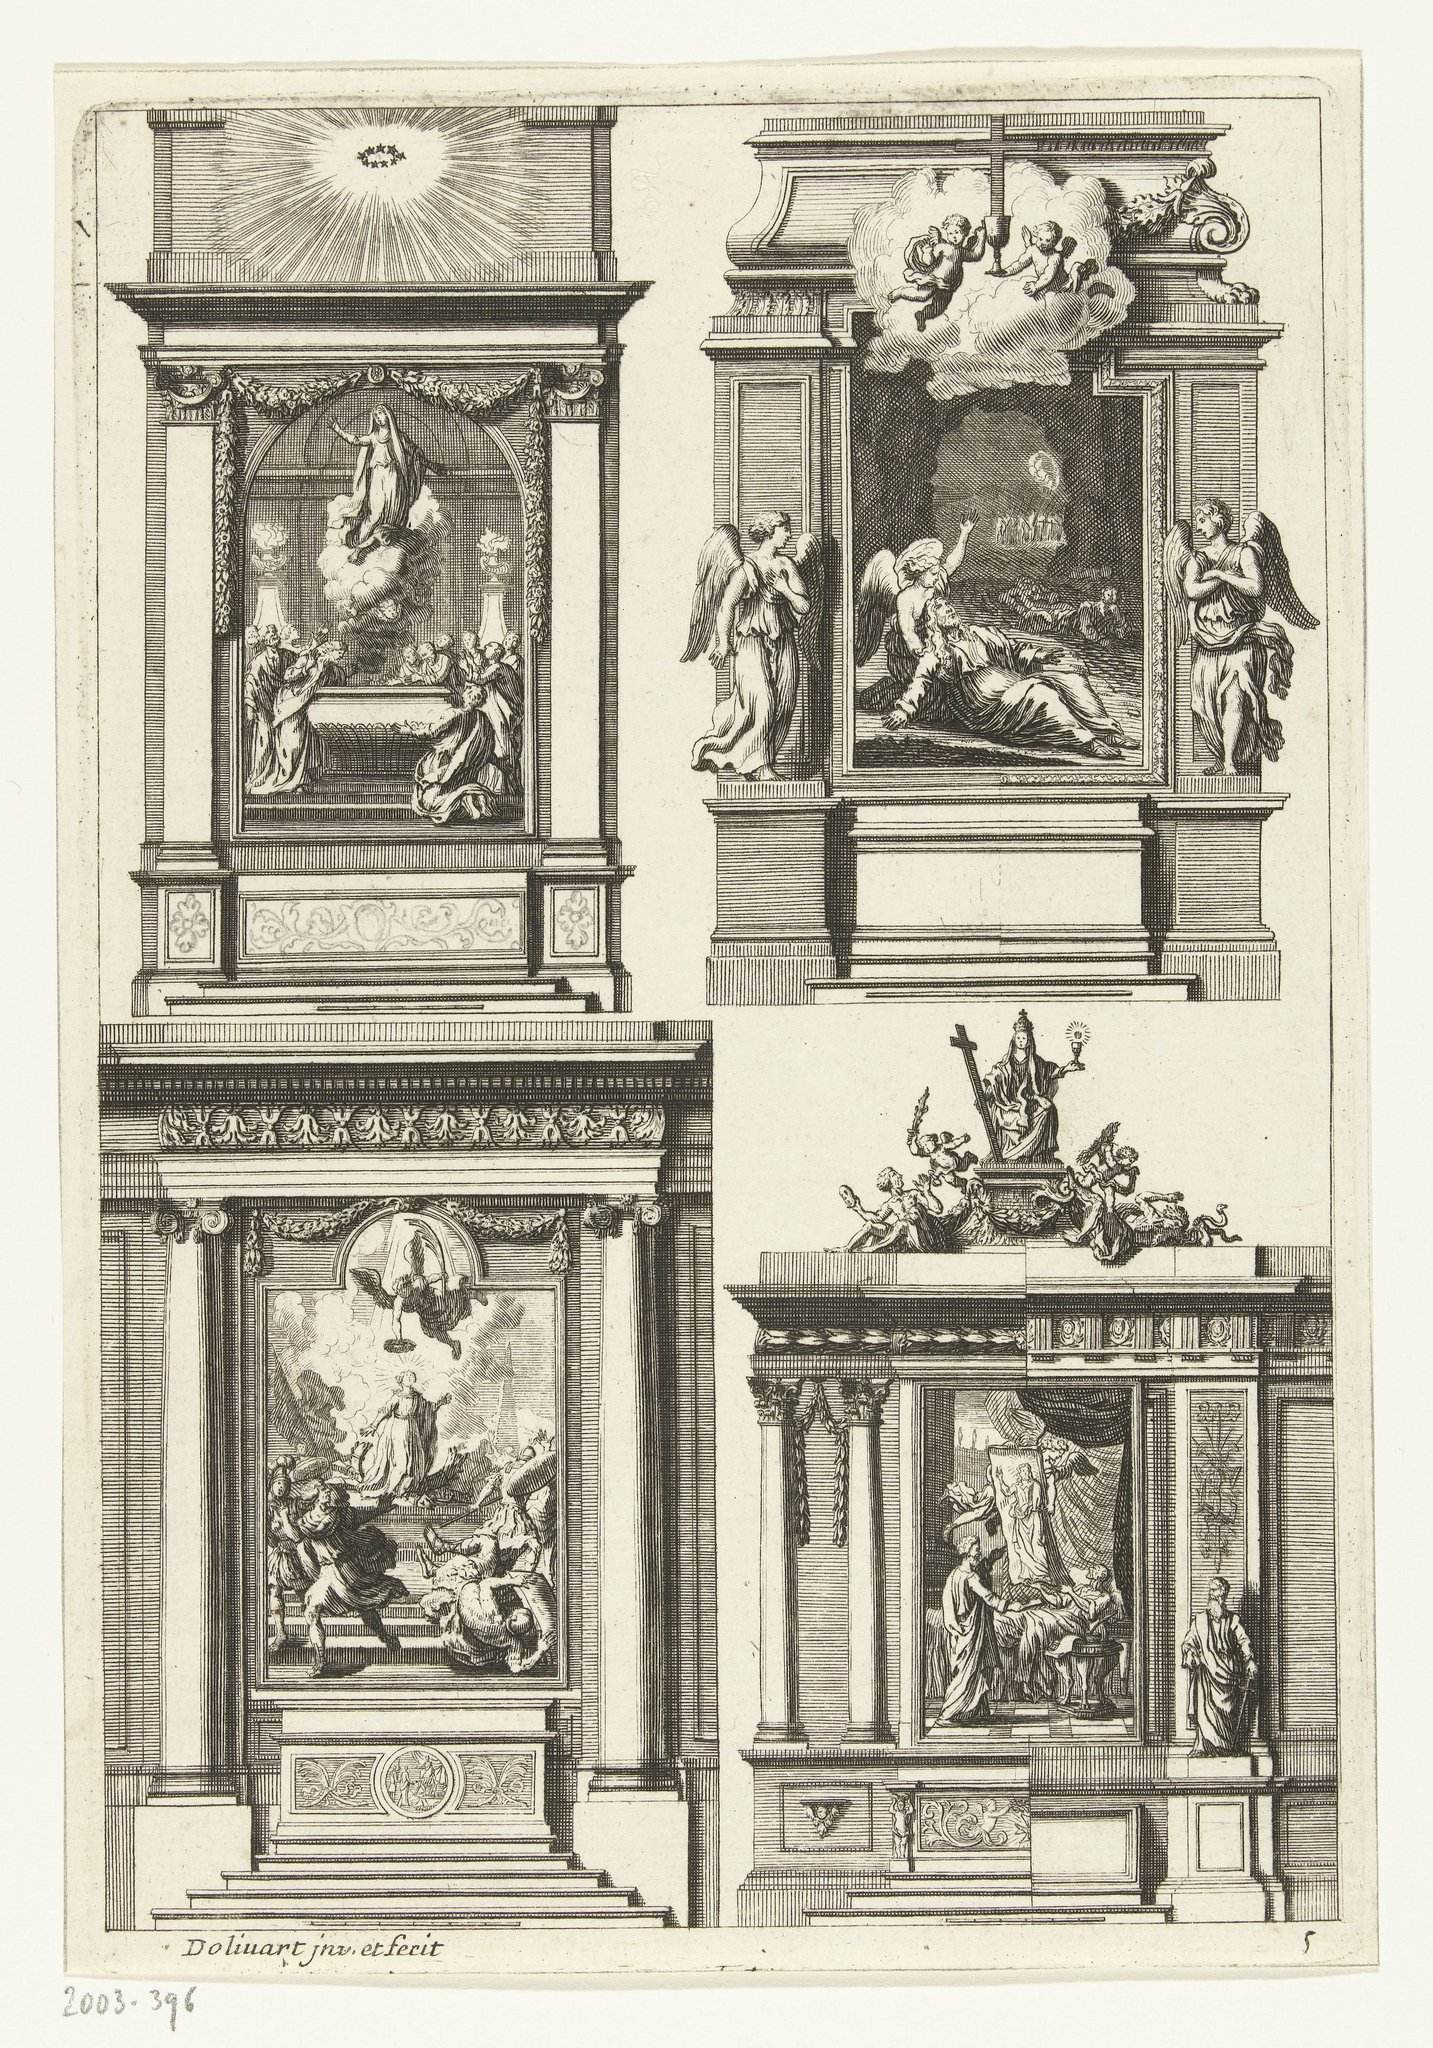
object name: print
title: Vier ontwerpen voor altaren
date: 1690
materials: paper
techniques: etching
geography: france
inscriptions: number: ‘5’, signature: ‘Dolivart jnv. et fecit’